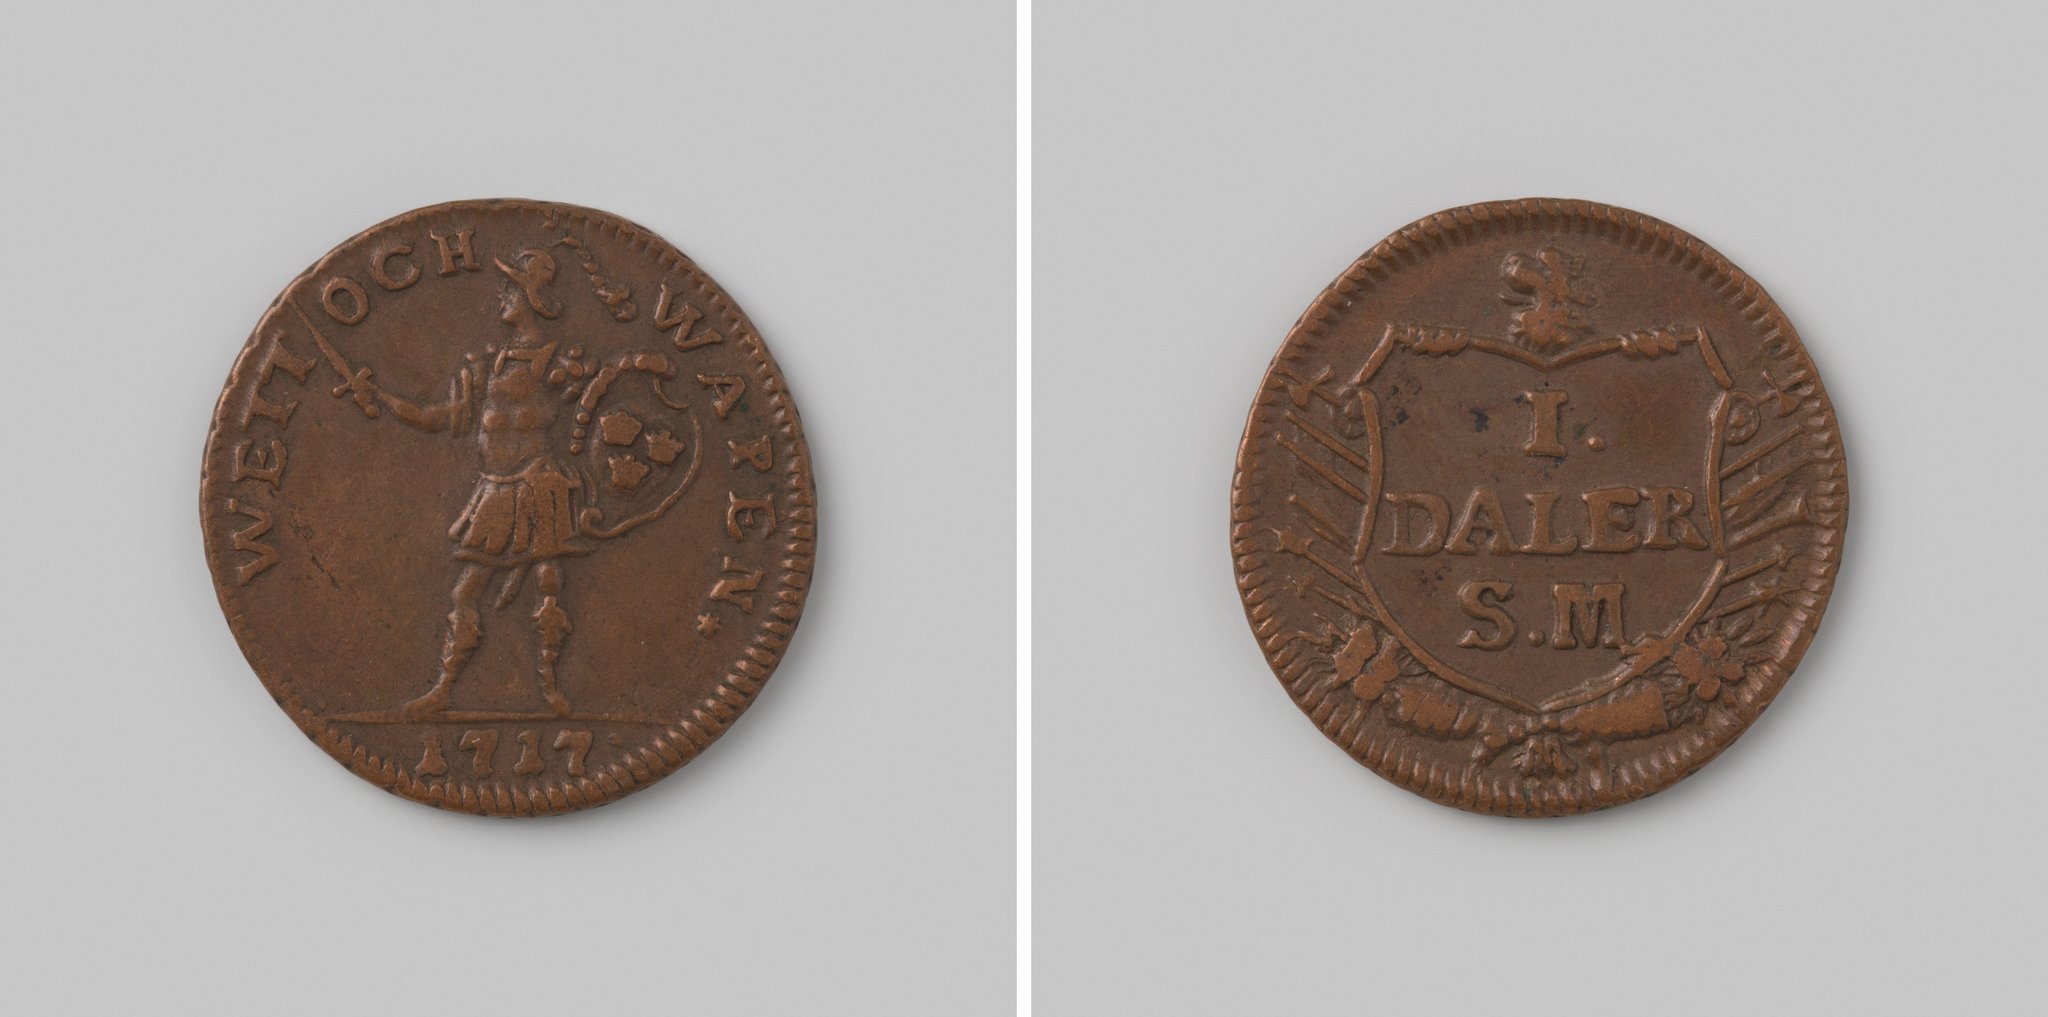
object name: coin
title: Zweden, Karel XII, daler S[ilver] M[ynt],1717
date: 1717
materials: copper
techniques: striking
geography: slot rörstrand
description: Koperen noodmunt. Voorzijde: staande man met helm, in rechterhand zwaard, in linker wapenschild. In afsnede jaartal. Keerzijde: binnen versierd wapenschild in drie regels waarde-aanduiding. Kabelrand.